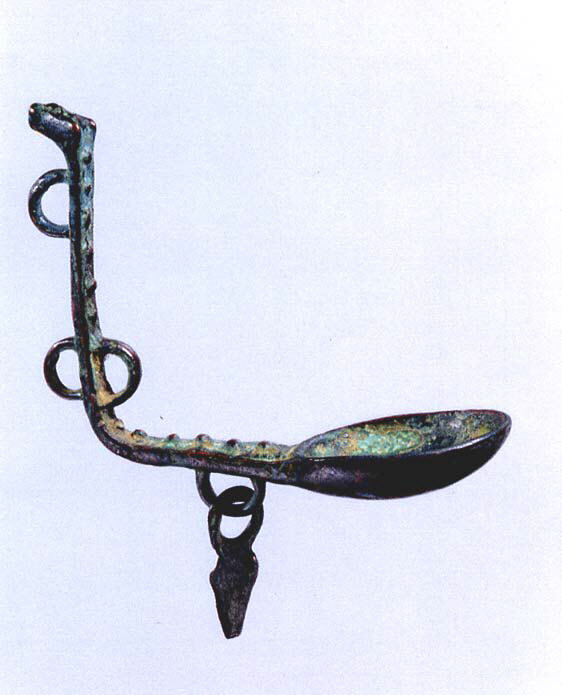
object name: spoon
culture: northwest chinese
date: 1300-1001 BCE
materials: bronze